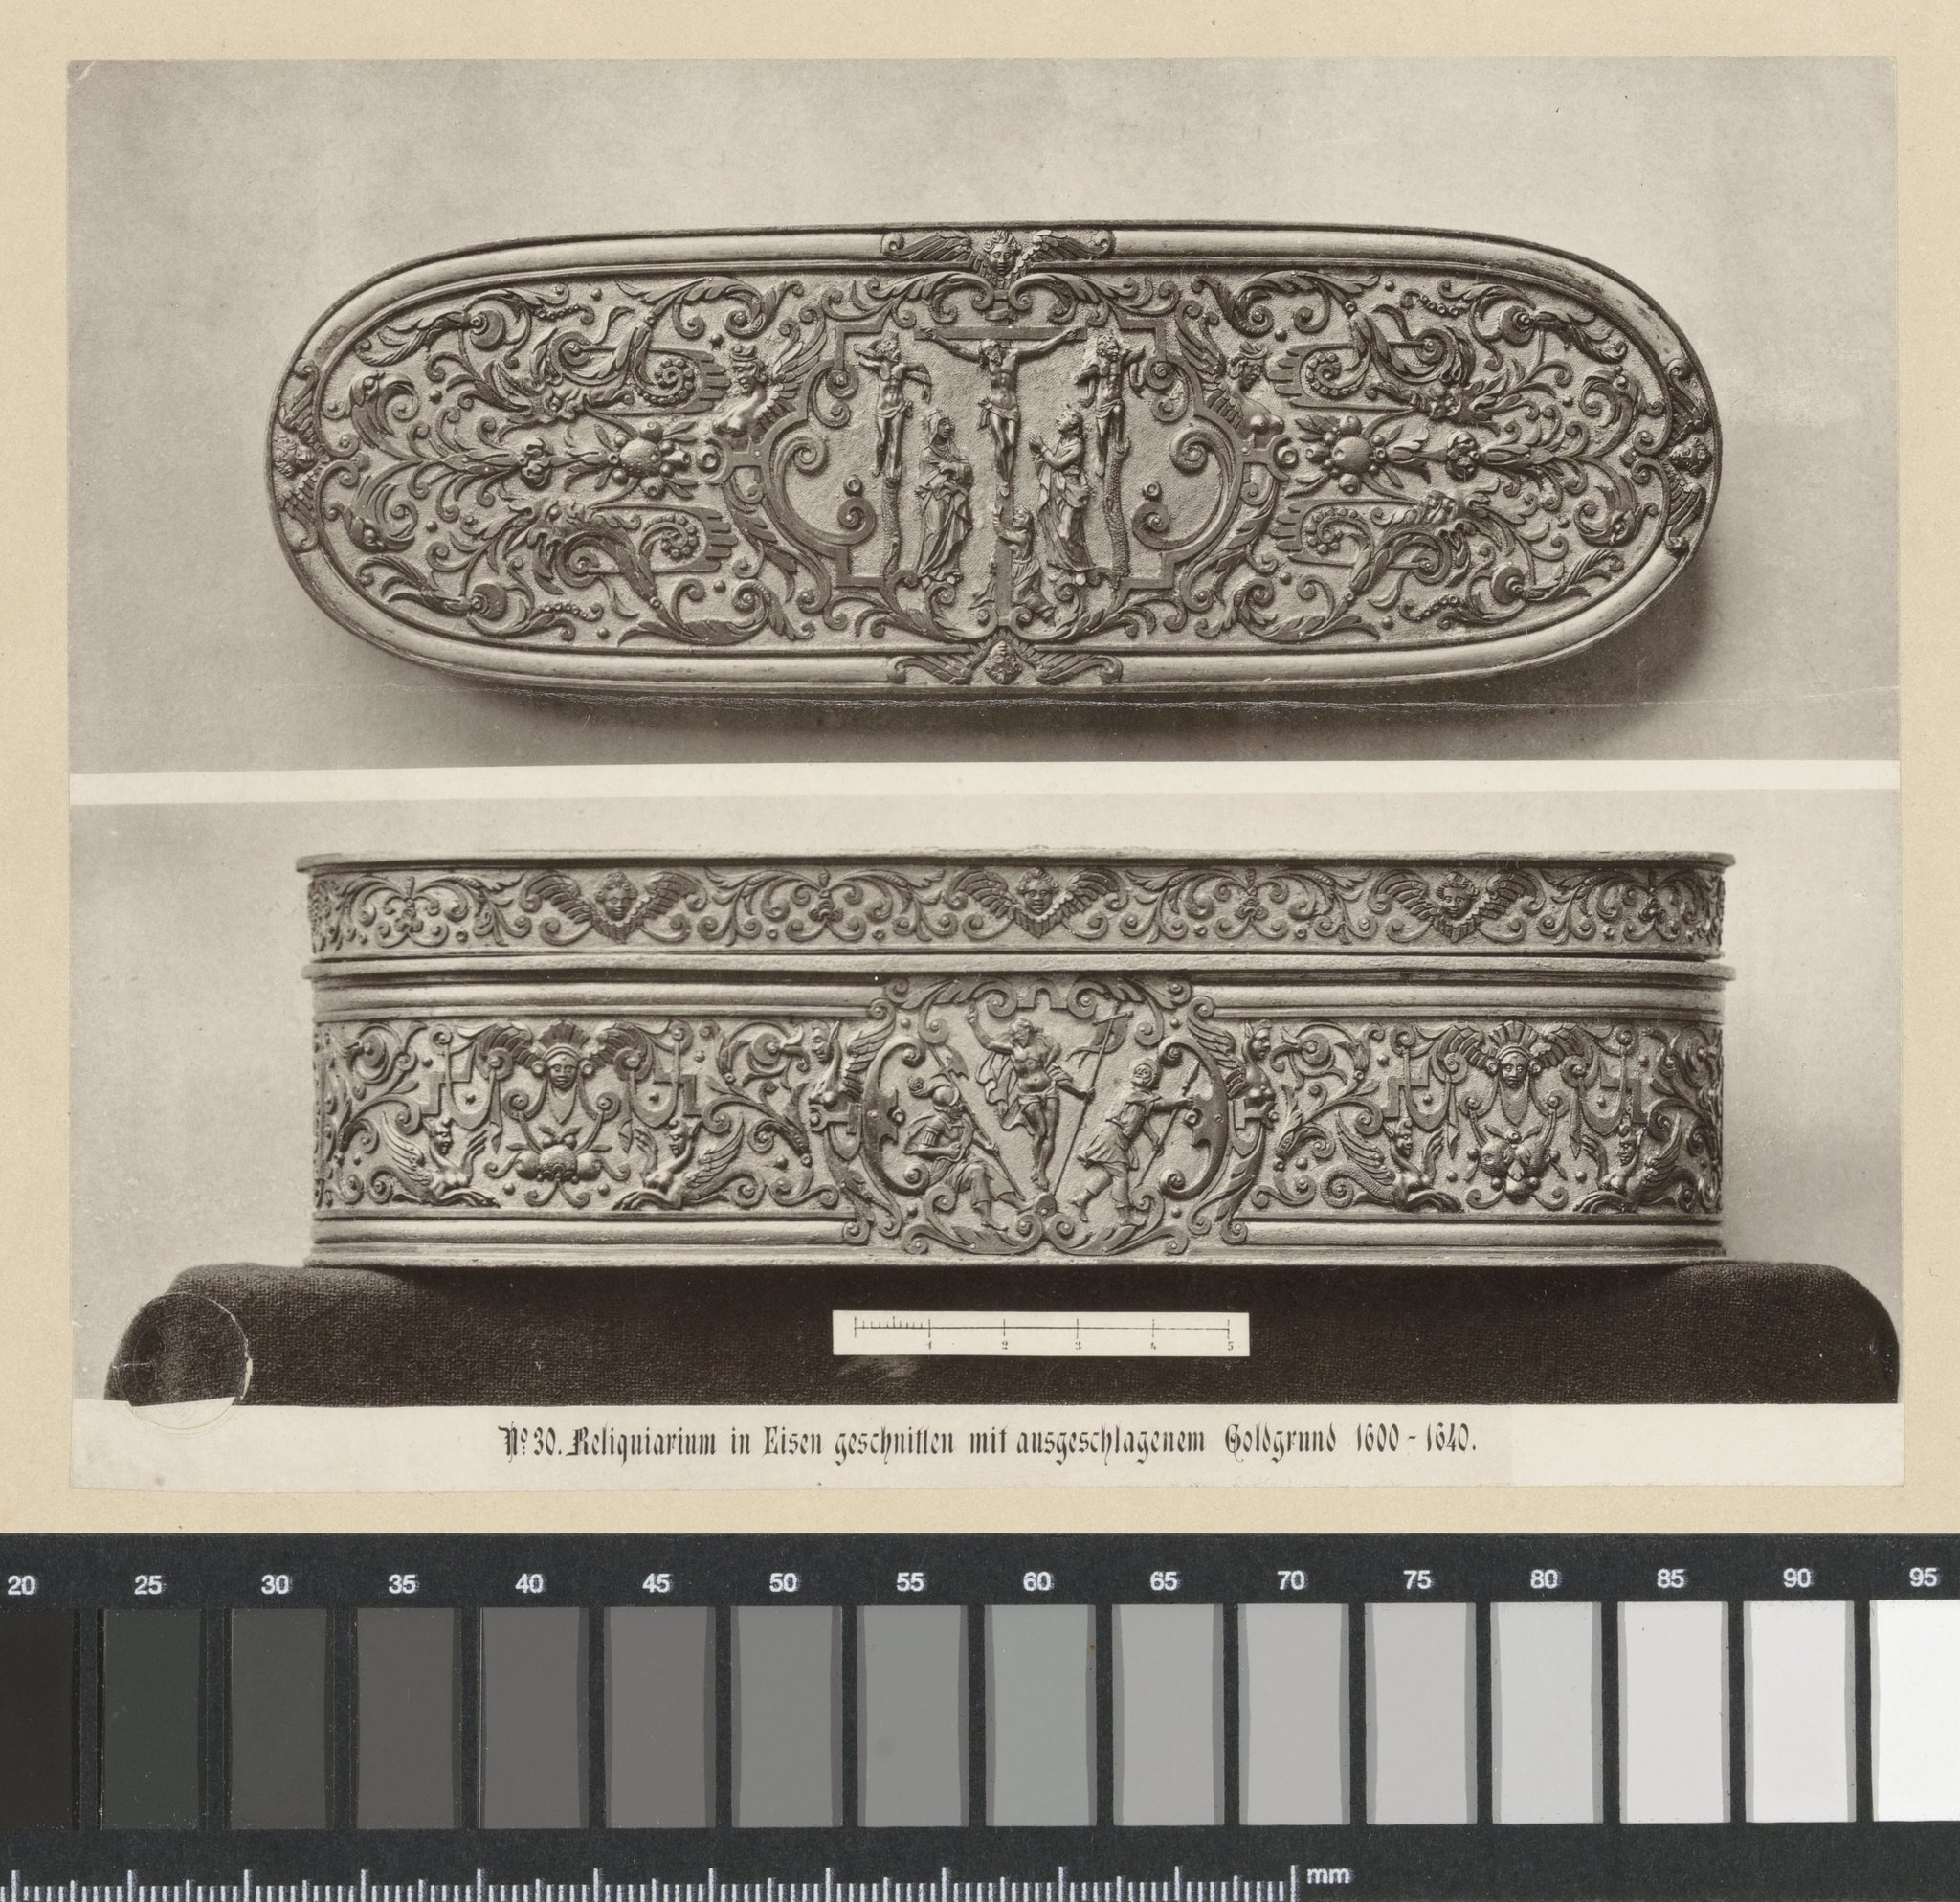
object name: photomechanical print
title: IJzeren reliekkist met goudbeslag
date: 1869-1887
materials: cardboard, paper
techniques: photograph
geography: munich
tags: relics (and reliquaries), work of applied art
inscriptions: check stamp: ‘Bayerisches National-Museum’, collector's mark: Lugt 3937, inscription: ‘Bayerisches National-Museum’, number: ‘No. 30.’